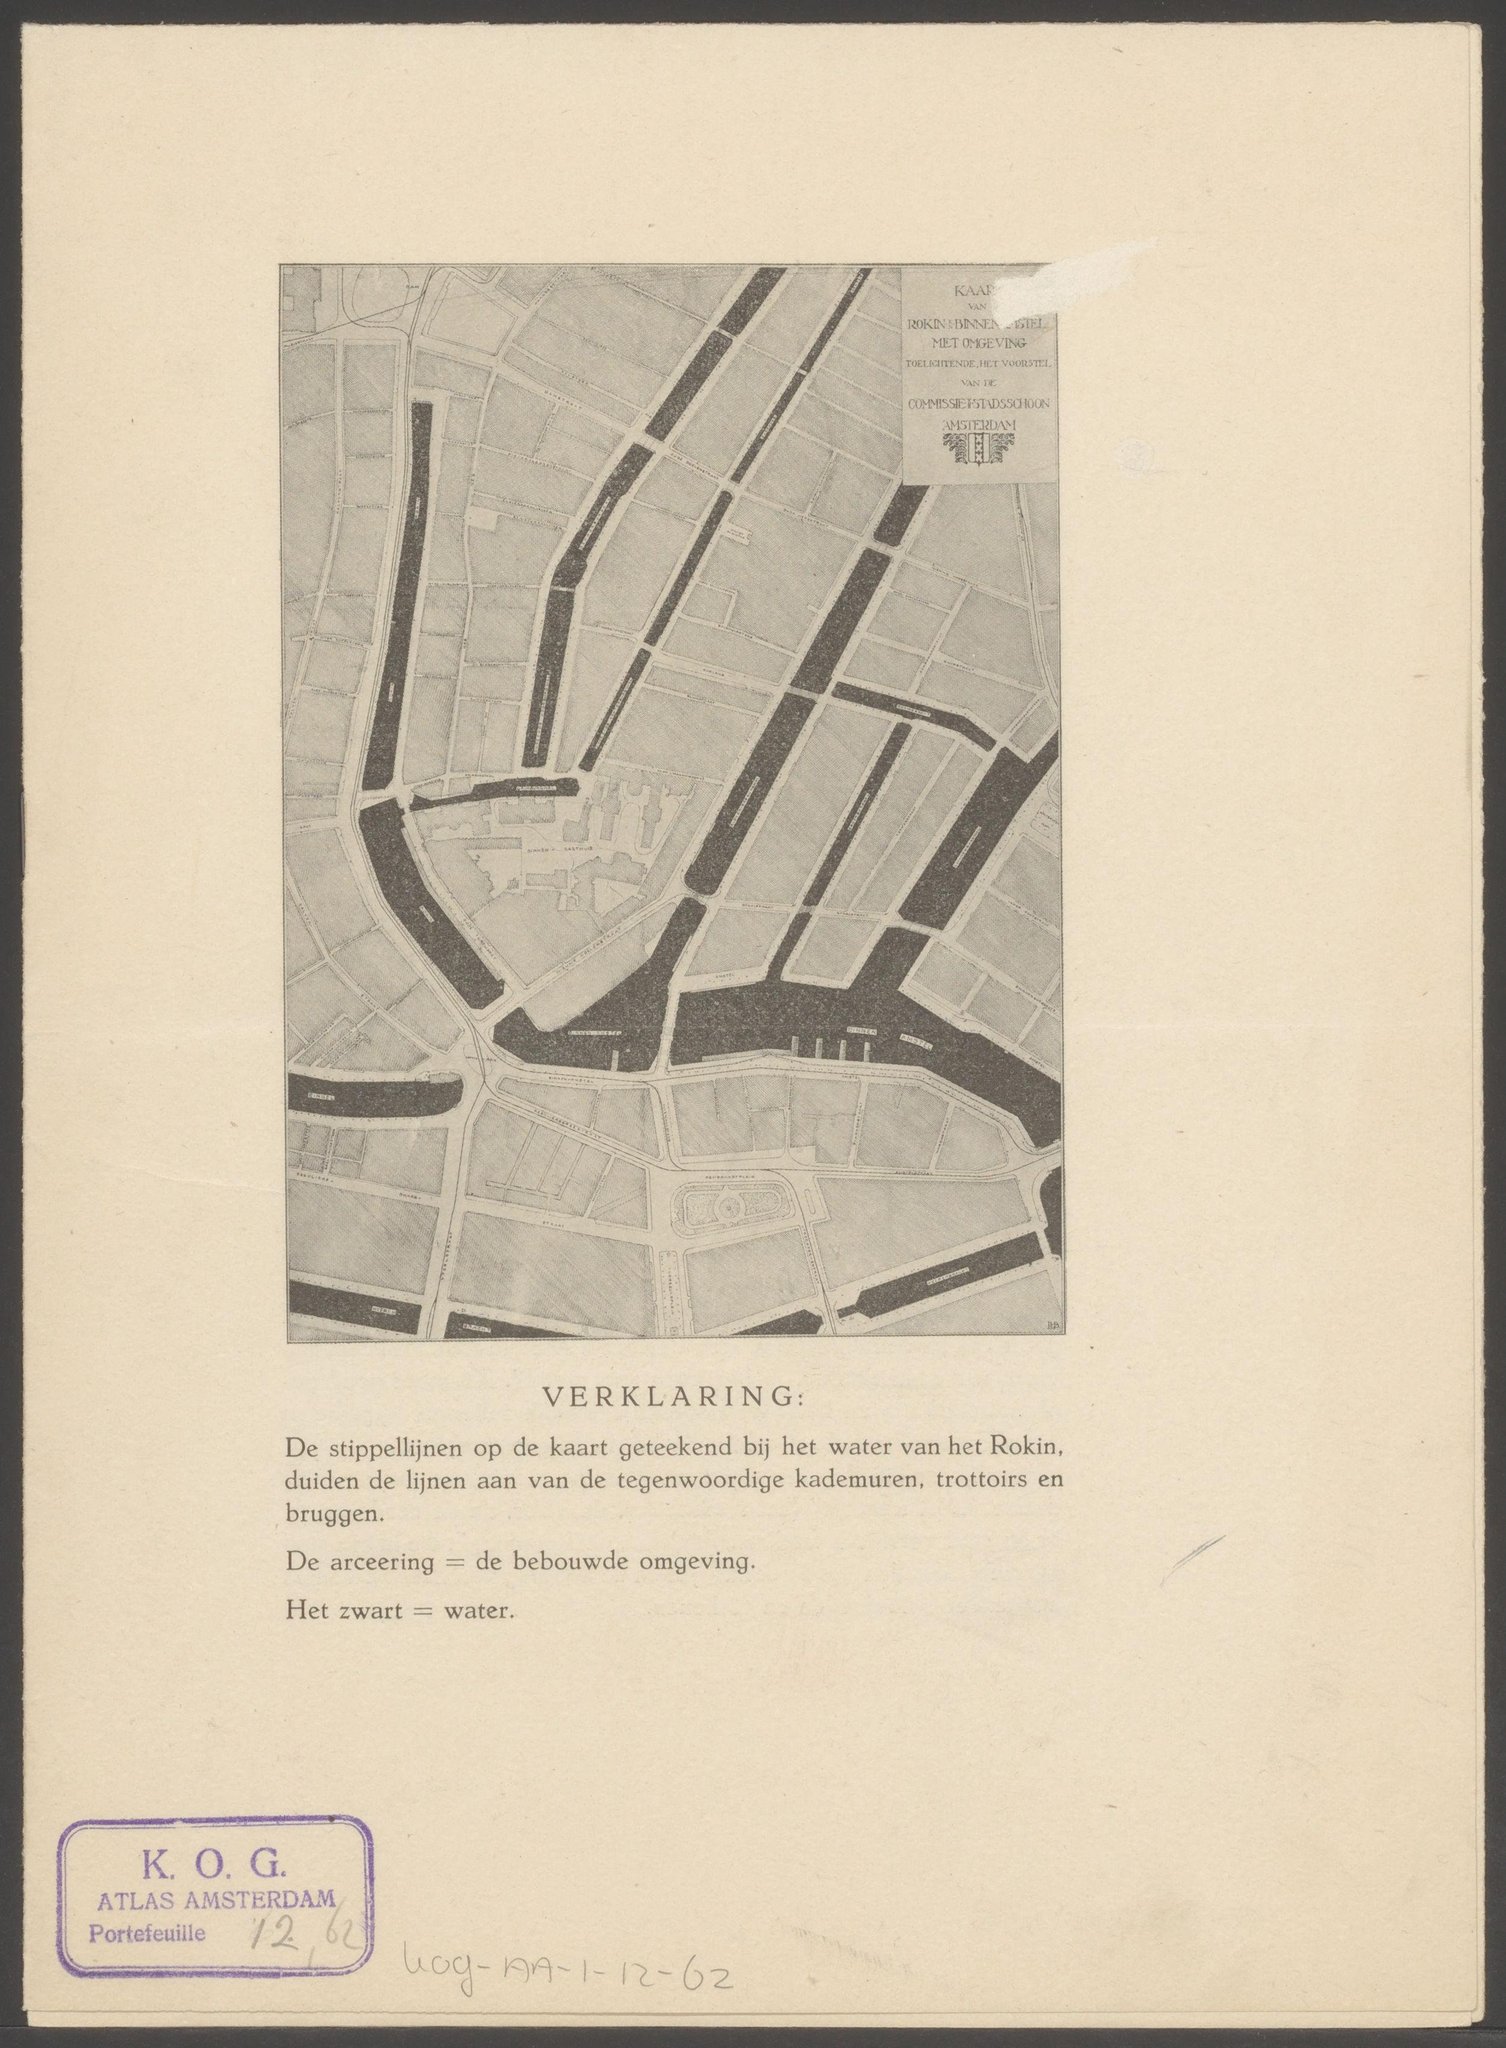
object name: text sheet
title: Tekstbladen met betoog tegen de demping van het Rokin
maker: Anonymous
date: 1906-1919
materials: metal, paper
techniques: letterpress printing, stapling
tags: city-view in general; 'veduta', plan ~ architecture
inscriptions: collector's mark: ‘12,62’ Lugt 1641b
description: Onderwerpsrubriek binnen de Atlas Amsterdam: Rokin, Rotterdammersloot, Rozengang, Rozengracht, Rozenstraat, Rusland, Rustenburgerstraat, Ruysdaelkade, Ruysdaelstraat, Ruyterkade (de), Ruyterweg (Admiraal de). Acht tekstbladen gebonden in een boekje met een betoog tegen de demping van het Rokin.